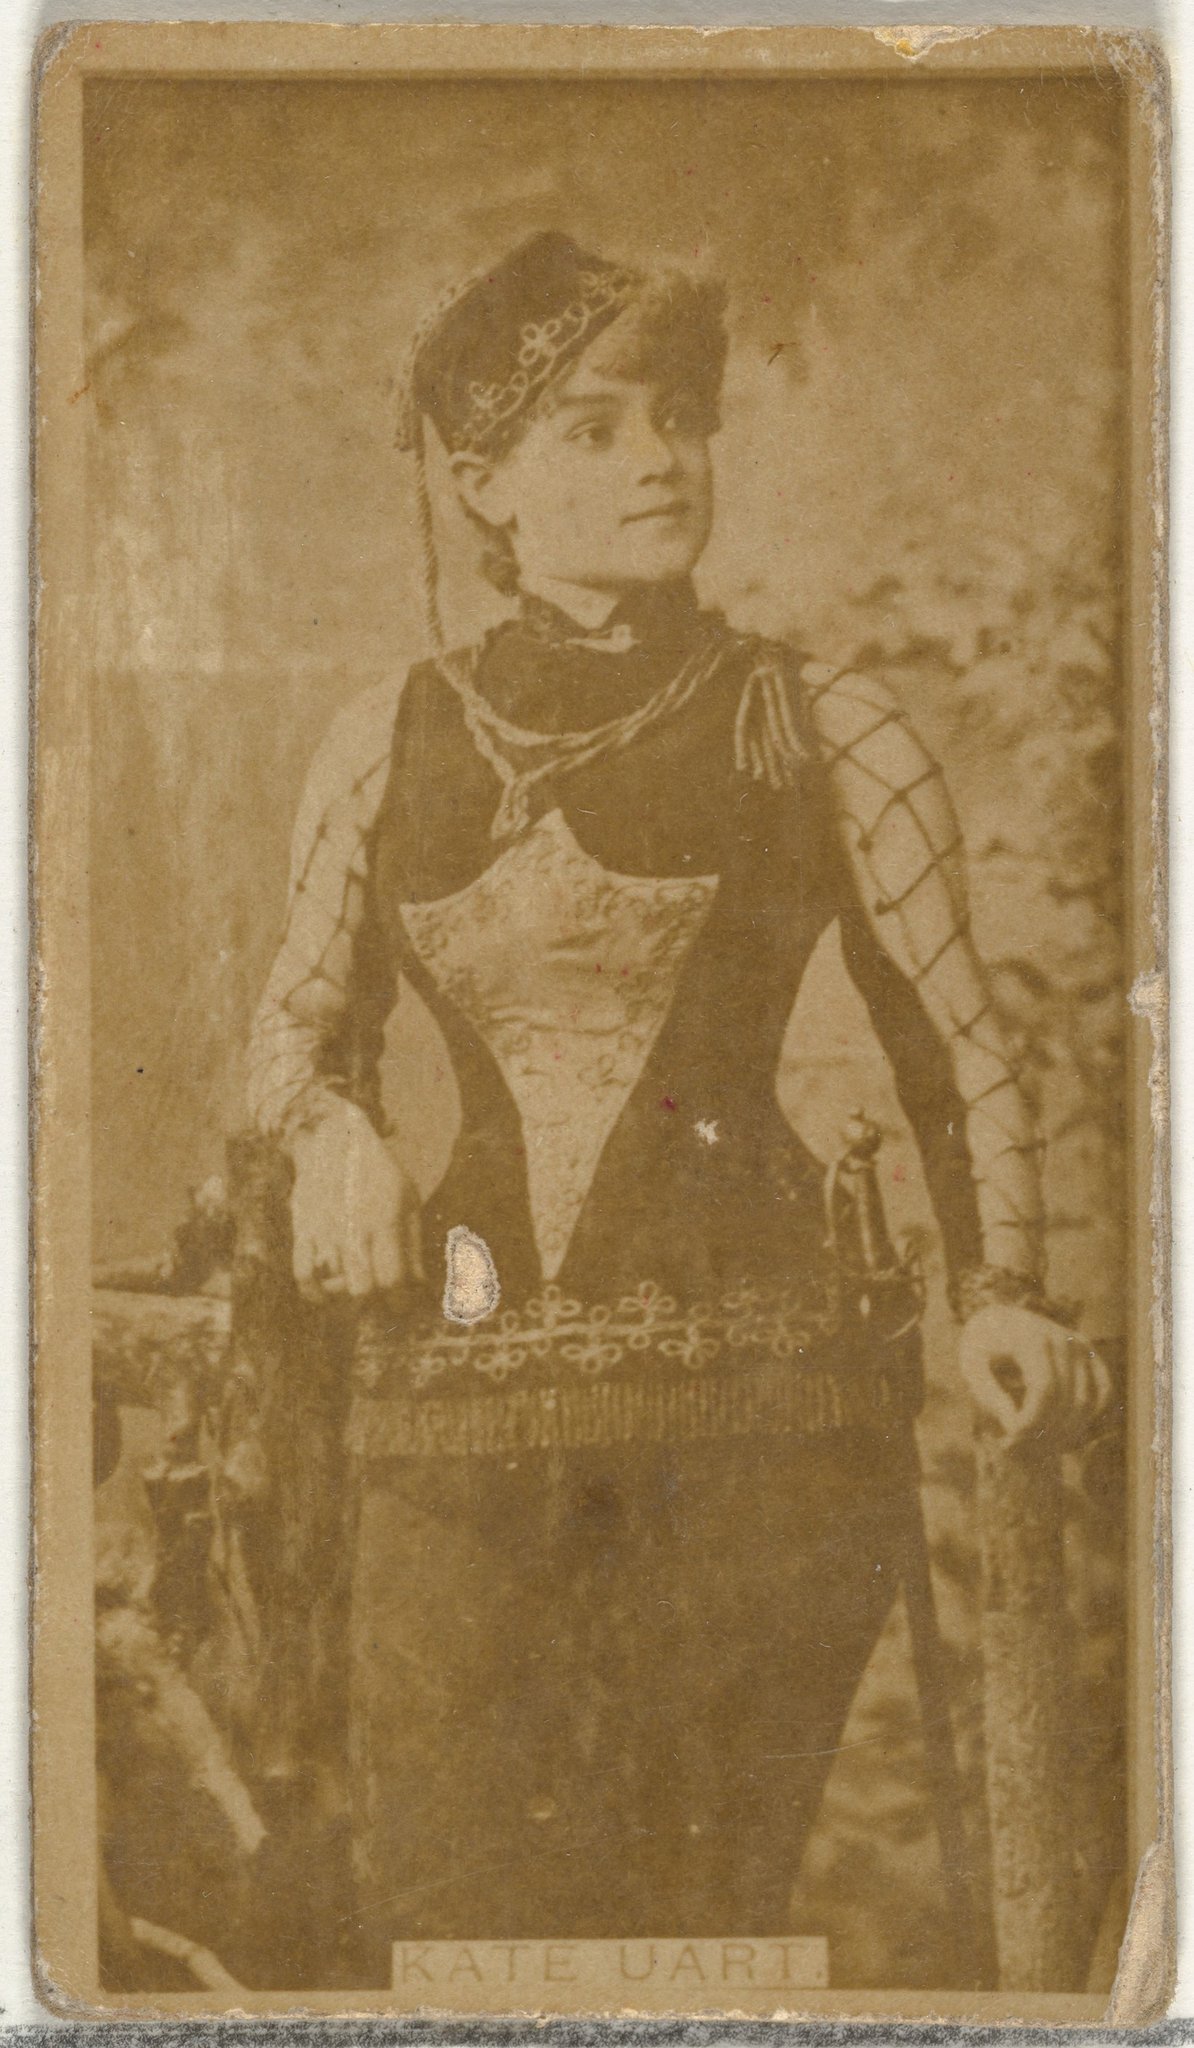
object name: photograph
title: Kate Uart, from the Actors and Actresses series (N145-8) issued by Duke Sons & Co. to promote Duke Cigarettes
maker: w. duke, sons & co.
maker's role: publisher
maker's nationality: american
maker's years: 1870-1920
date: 1891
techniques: albumen silver print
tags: portraits,women,actresses